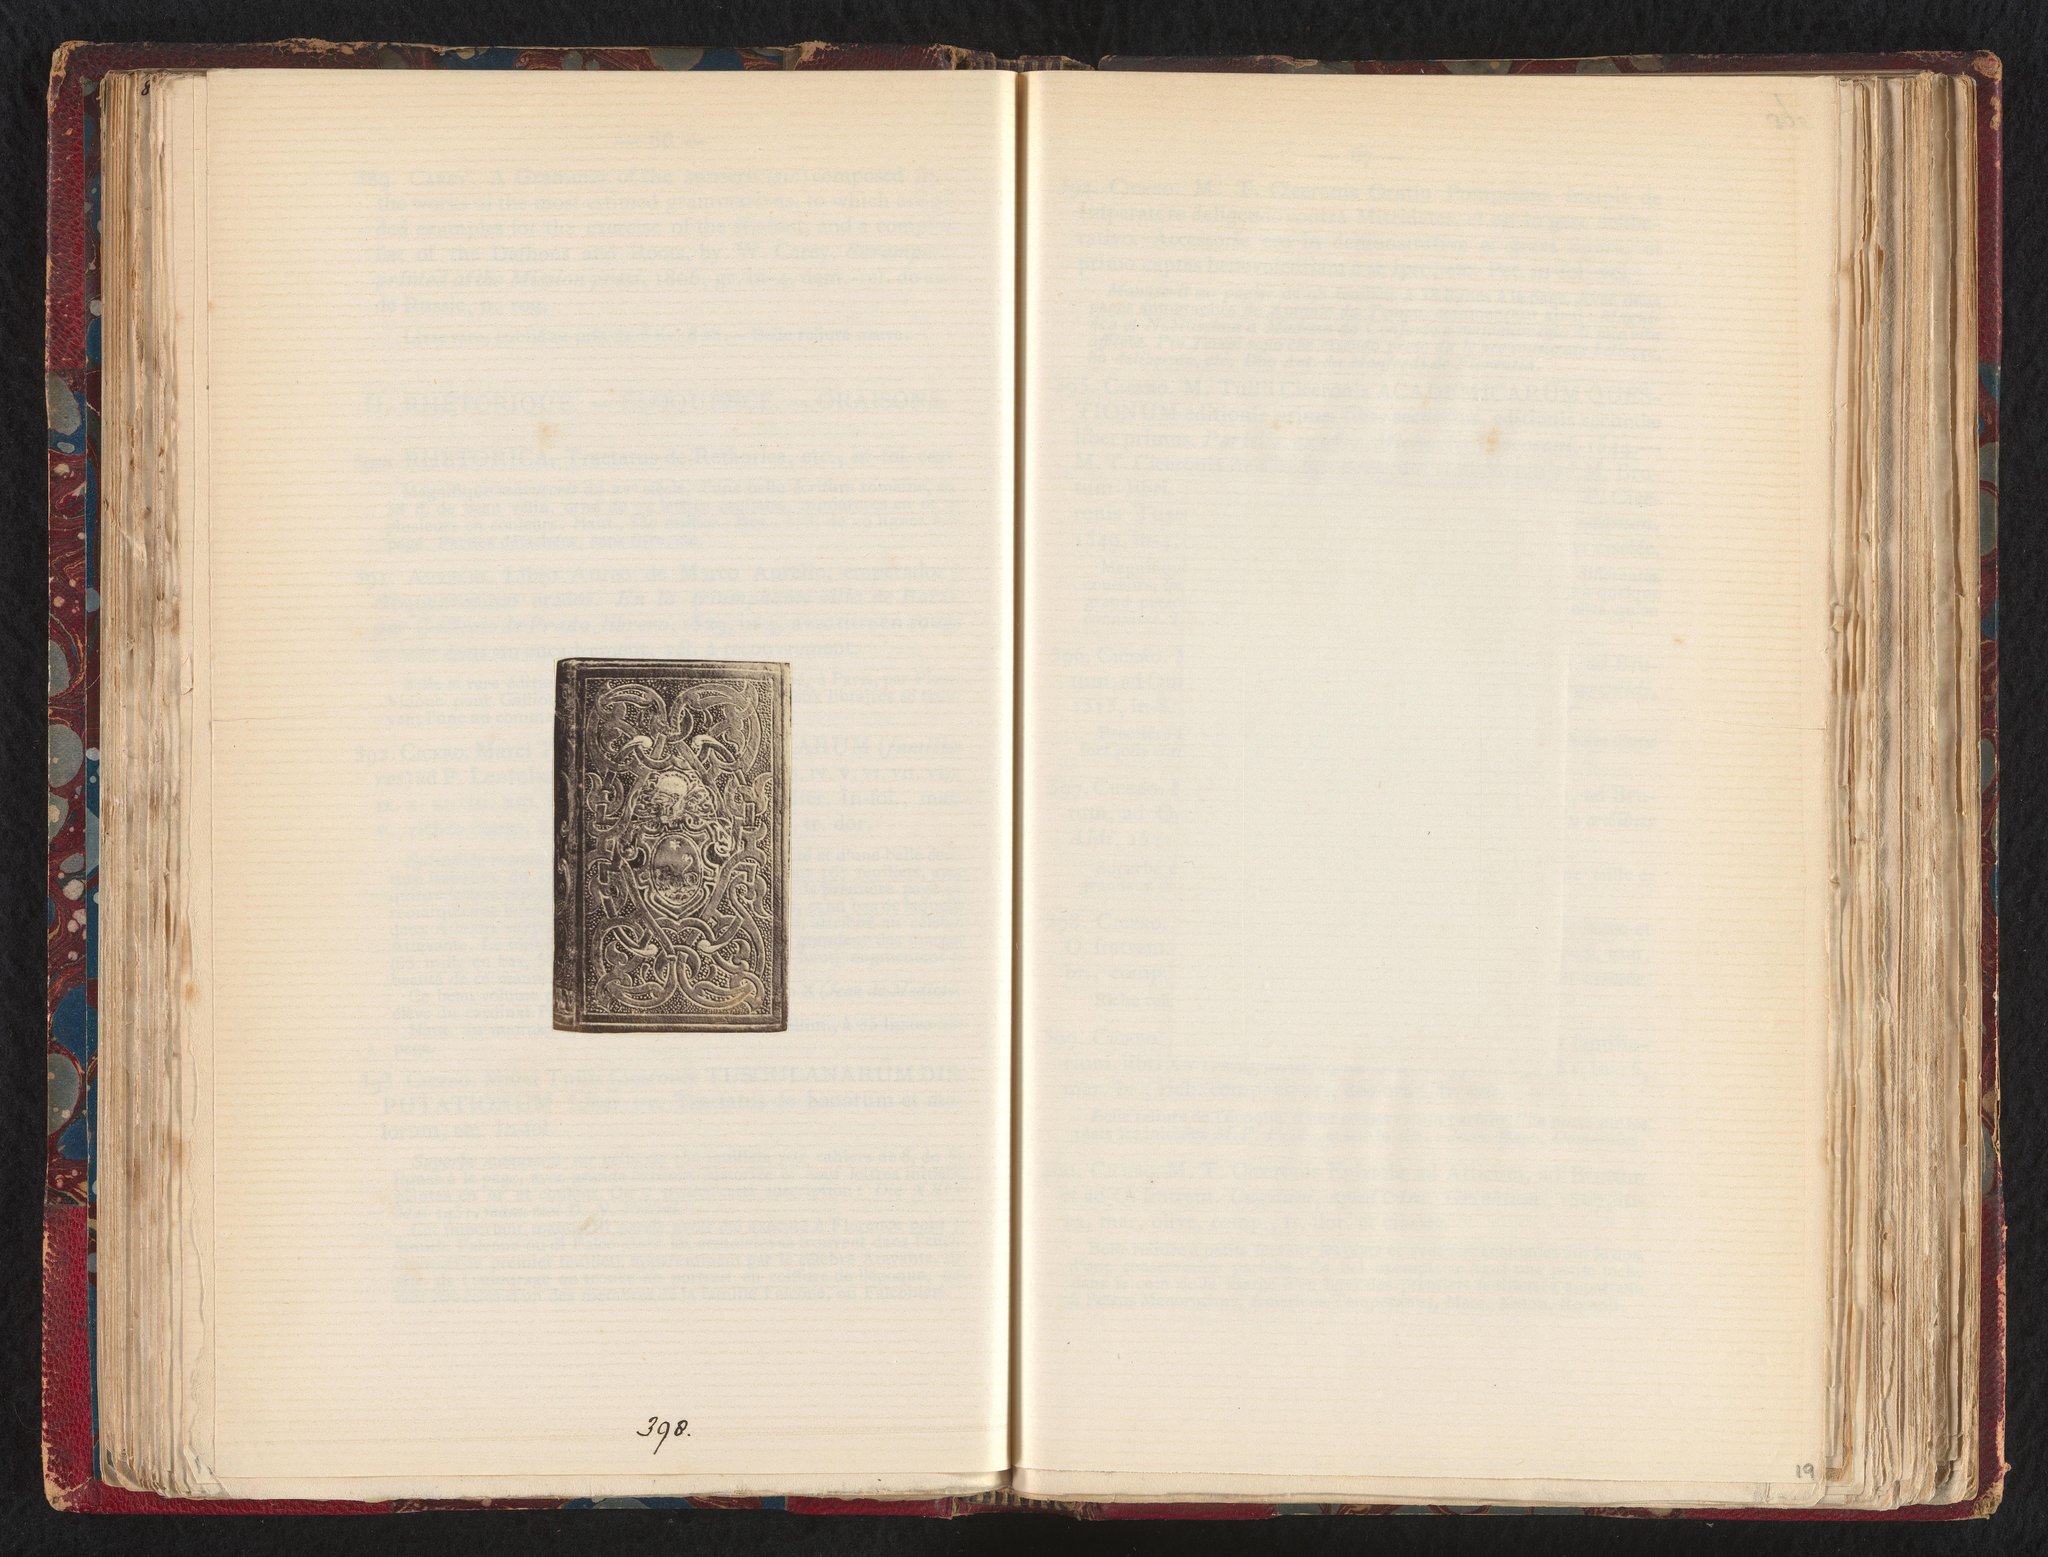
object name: photograph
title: Fotoreproductie van boekomslag van M.T. Ciceronis Epistolae ad Atticum, Brutum et Q. fratrem. uit 1548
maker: Anonymous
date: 1863-1868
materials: paper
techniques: albumen print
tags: book-cover, binding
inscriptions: number: ‘398’